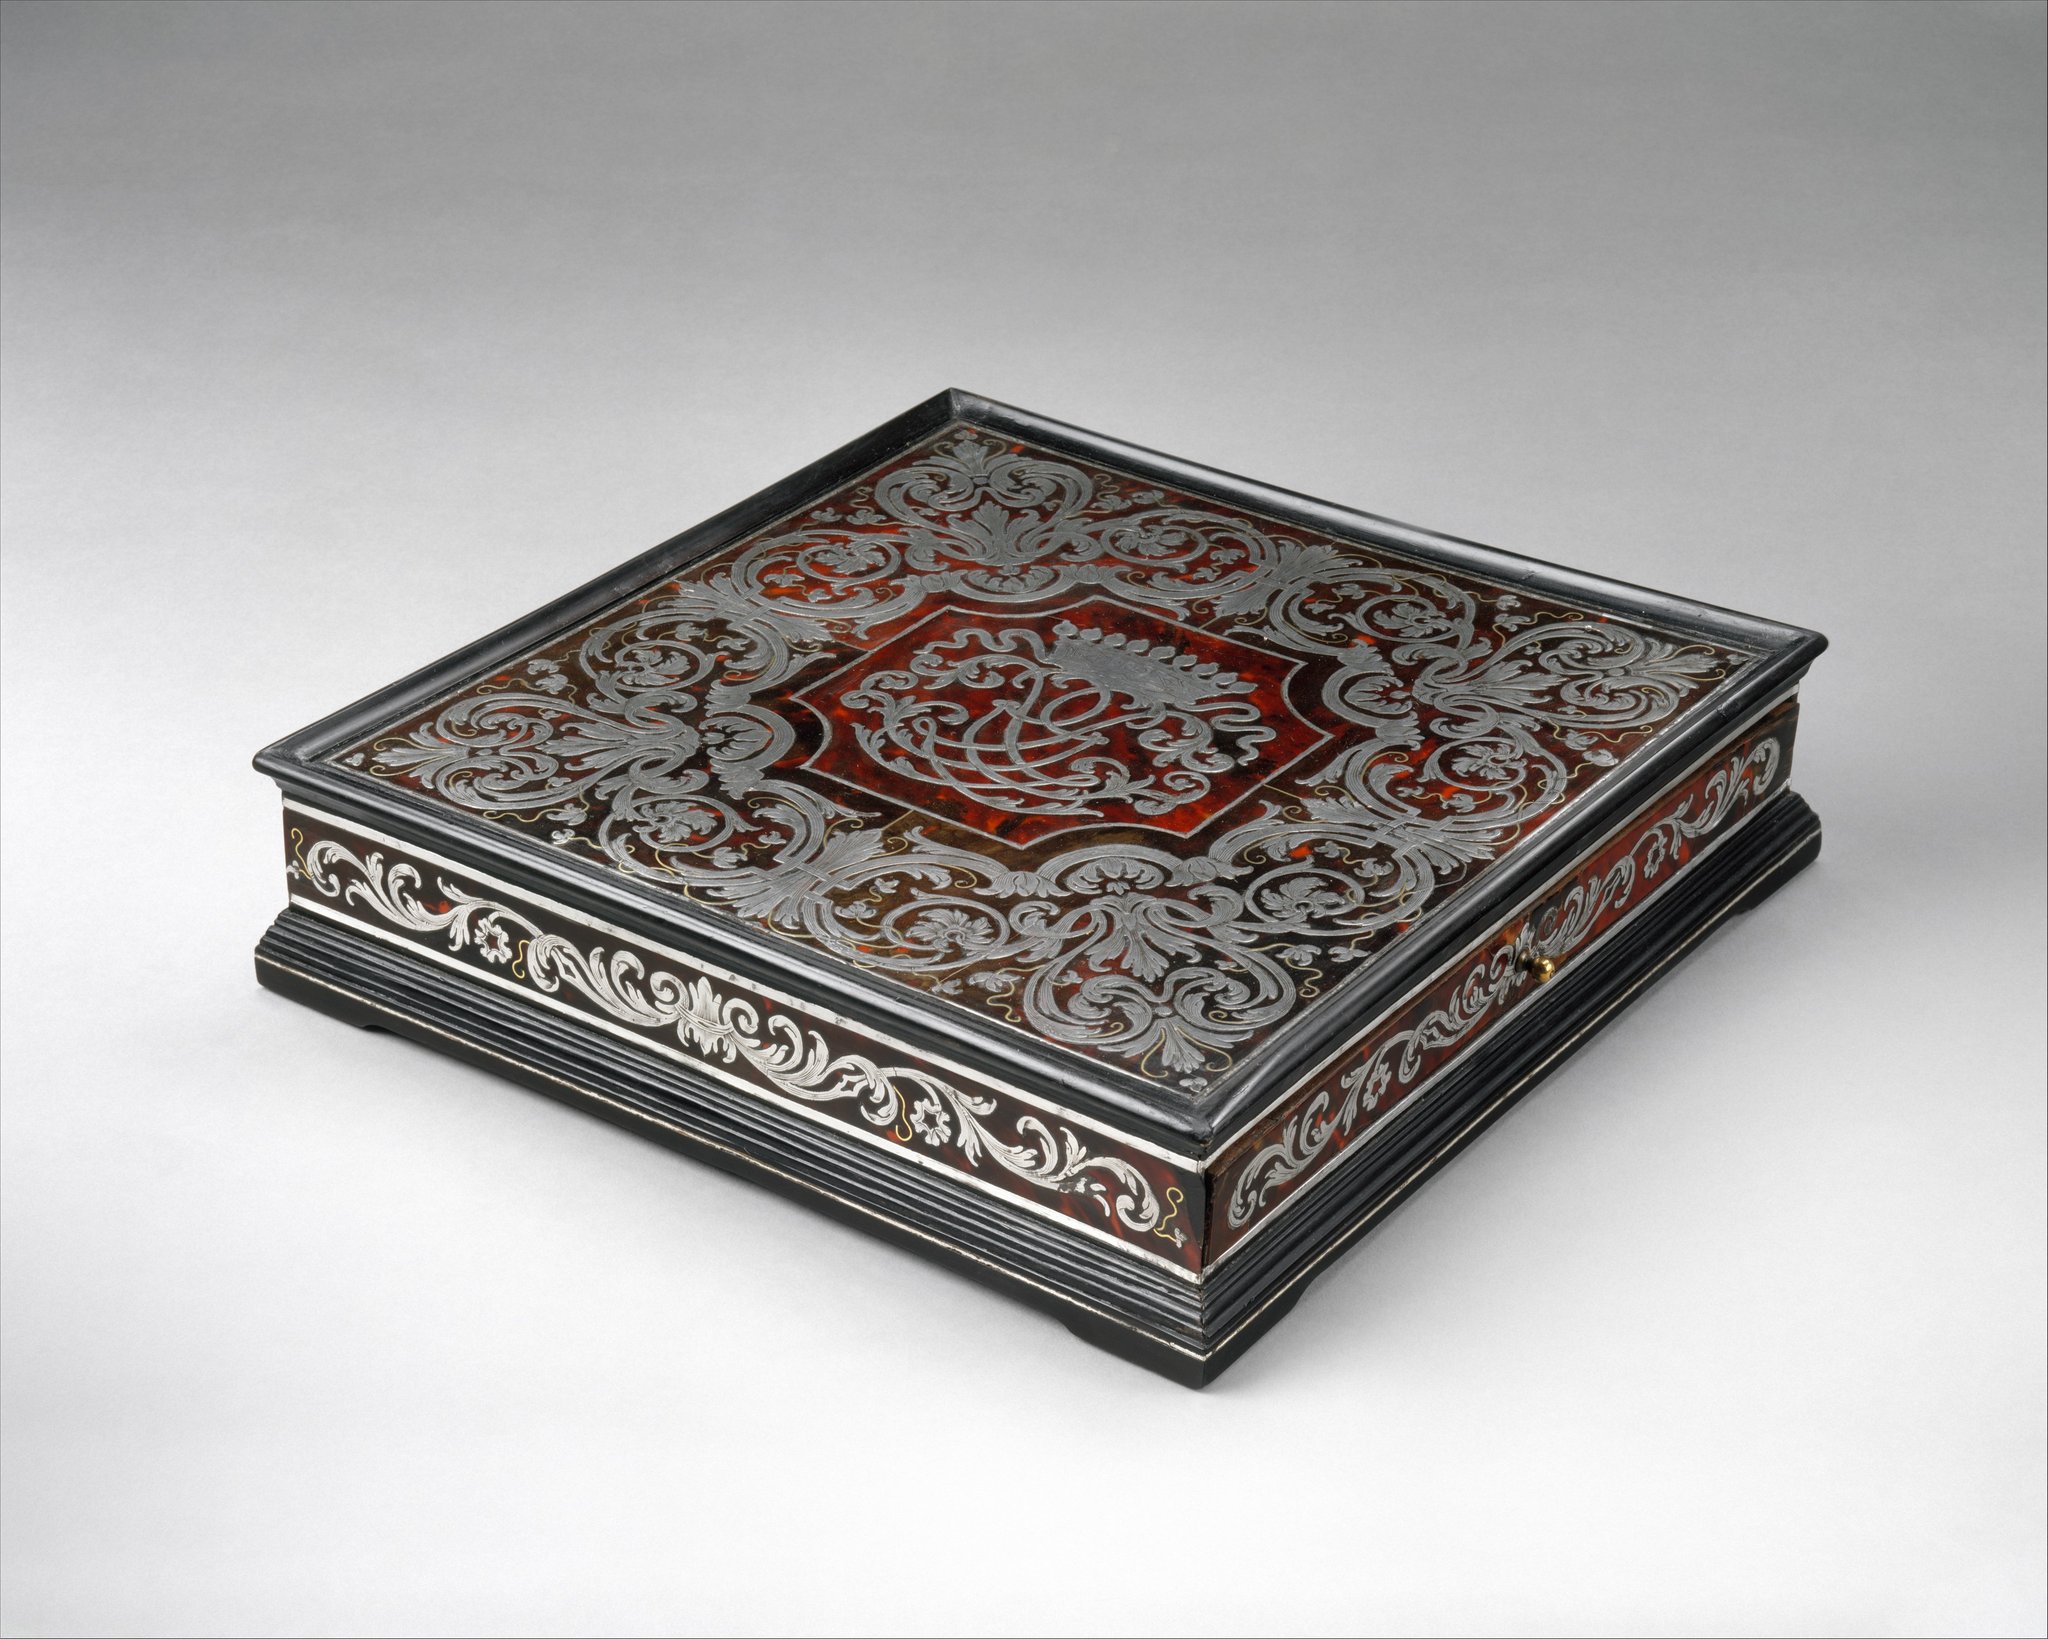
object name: writing box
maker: ferdinand plitzner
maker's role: maker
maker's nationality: german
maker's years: 1678-1724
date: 1715-1720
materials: brass, wood, pewter, silver, shell